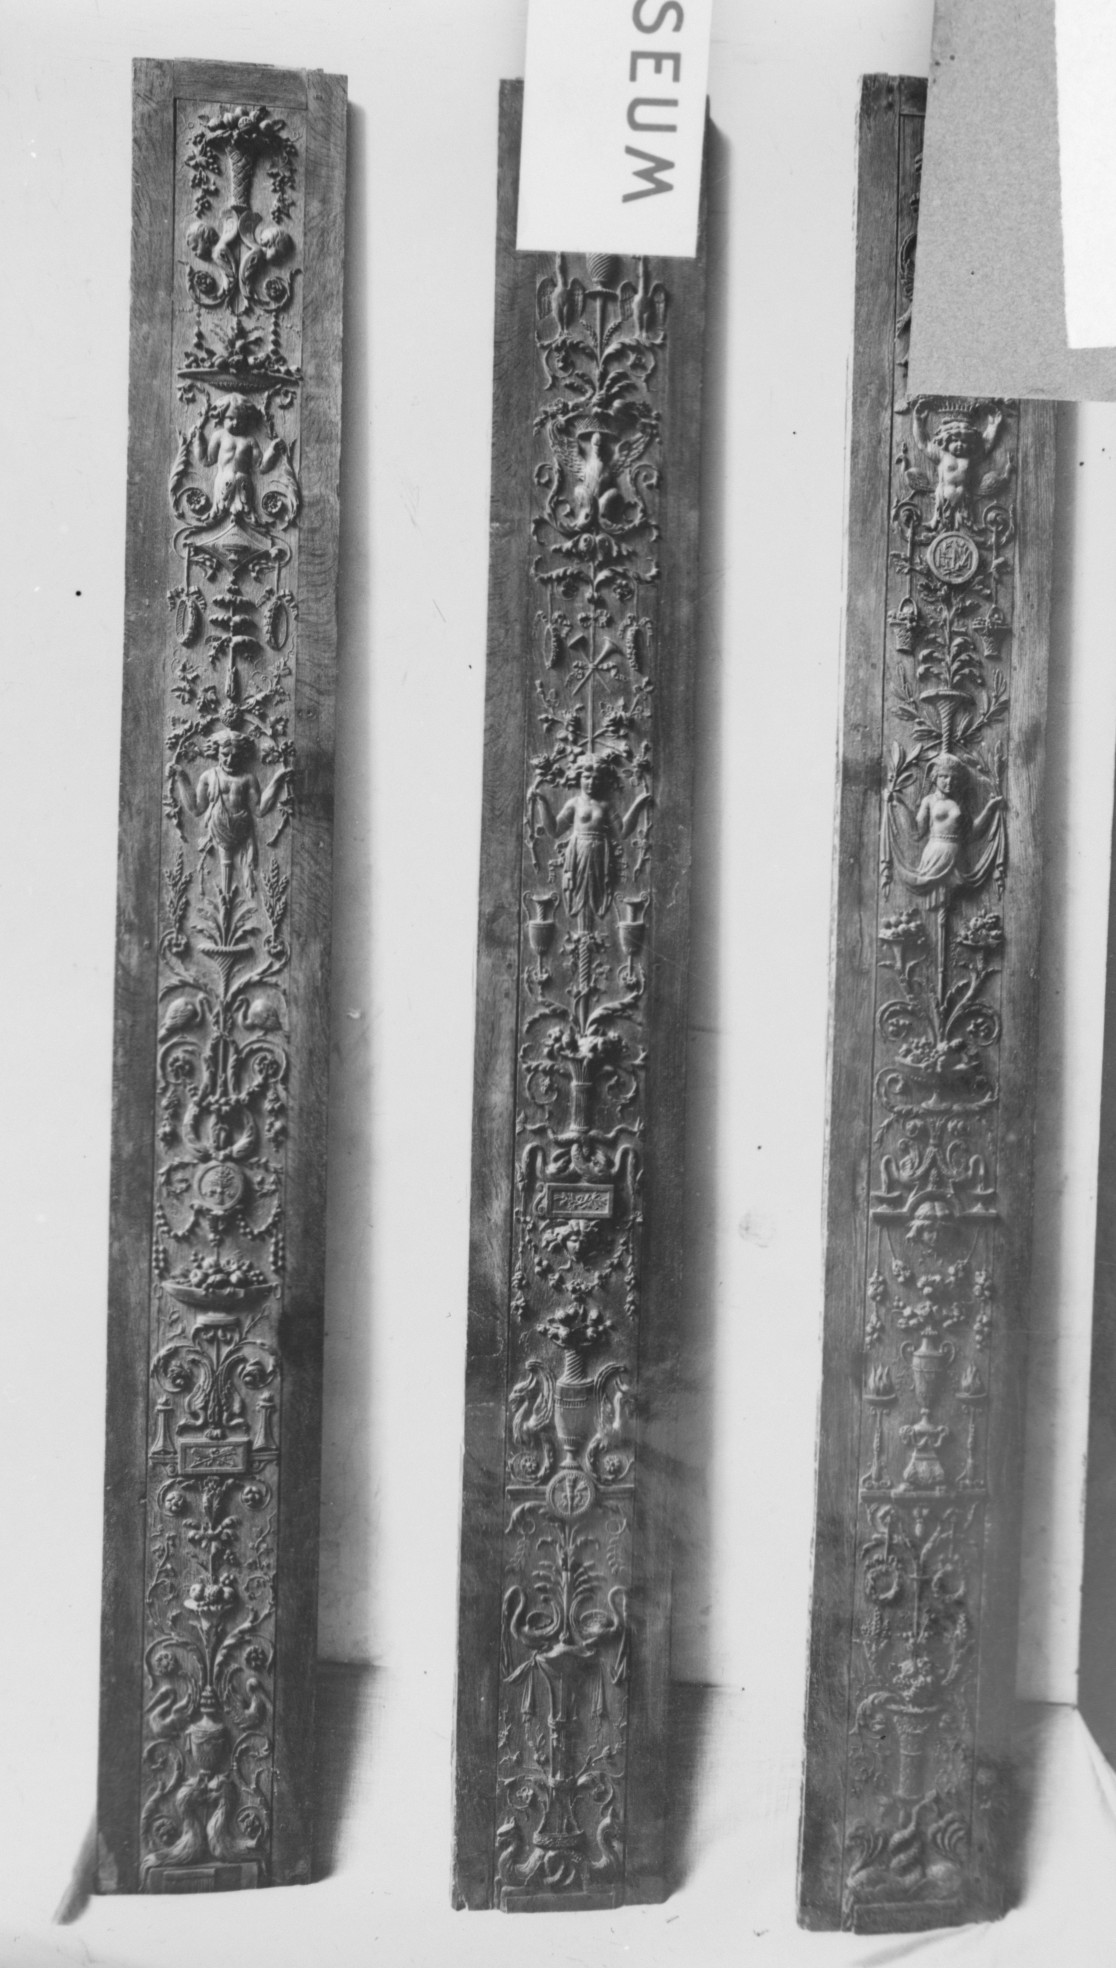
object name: pilaster panel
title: Pilaster panel (part of a set of eight)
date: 1701-1800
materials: wood